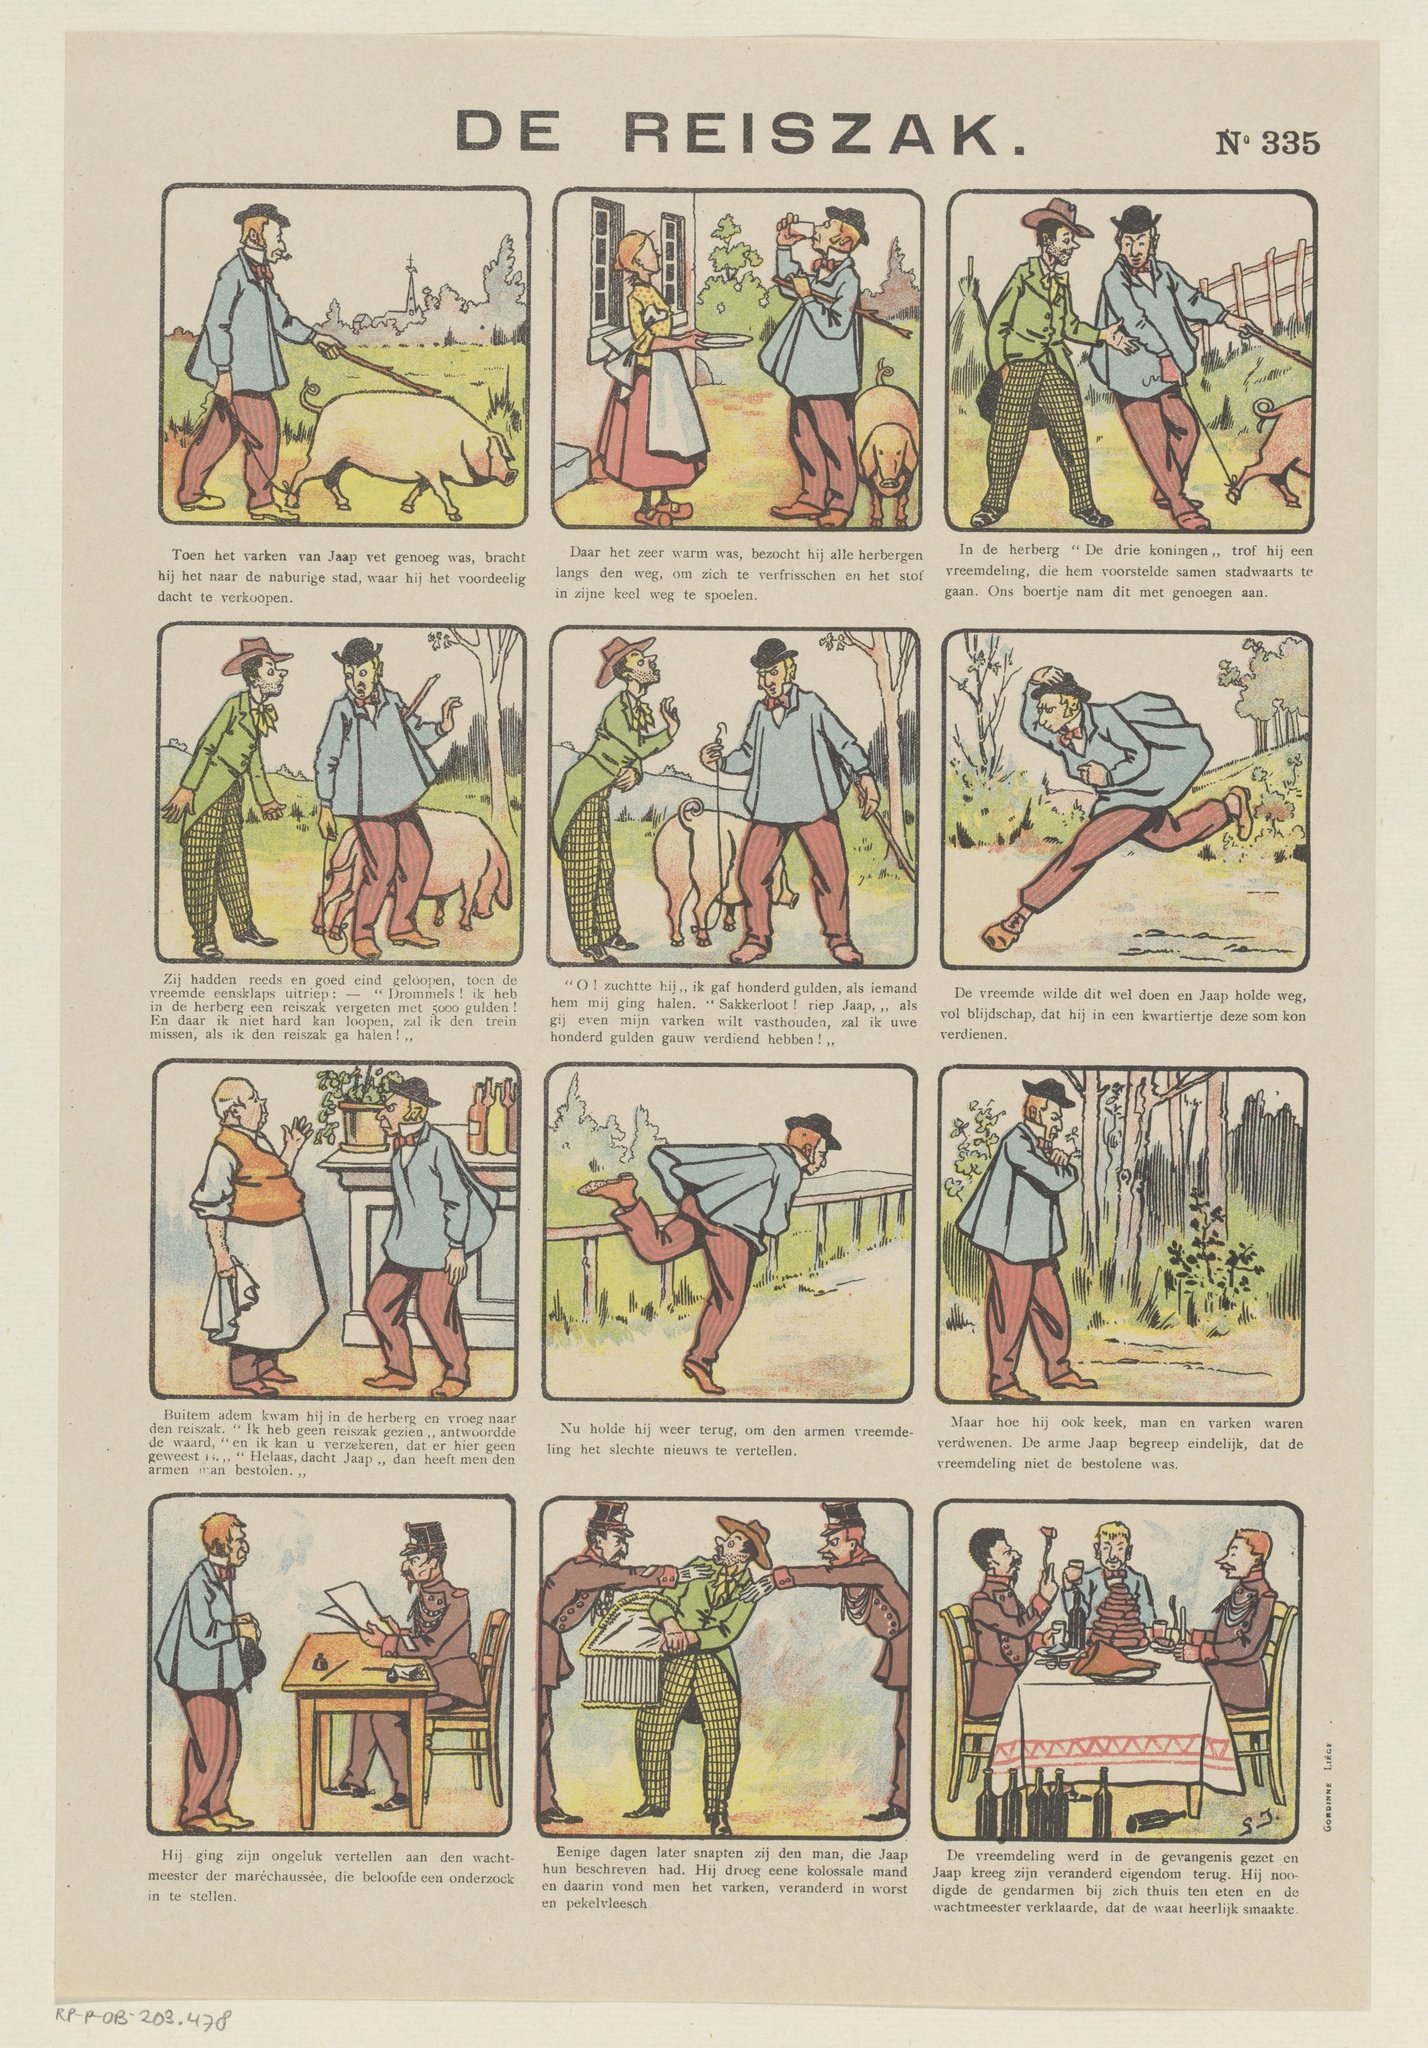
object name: print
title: De reiszak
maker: monogrammist g.j.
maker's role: print maker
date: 1894-1959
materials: paper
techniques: lithograph, letterpress printing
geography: liège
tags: pig, theft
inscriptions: collector's mark: Lugt 2760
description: Blad met 12 voorstellingen over Jaap die met zijn varken opweg naar de stad gaat. Bij een herberg ontmoet hij een vreemdeling die met hem meegaat. De vreemdeling beweert zijn tas te zijn vergeten in de herberg. Jaap rent terug om de tas te halen, maar wanneer hij terugkeert zijn de vreemdeling en zijn varken weg. Een aantal dagen later wordt de vreemdeling opgepakt met een mand vol worst. Onder elke afbeelding een onderschrift. Genummerd rechtsboven: No 335.